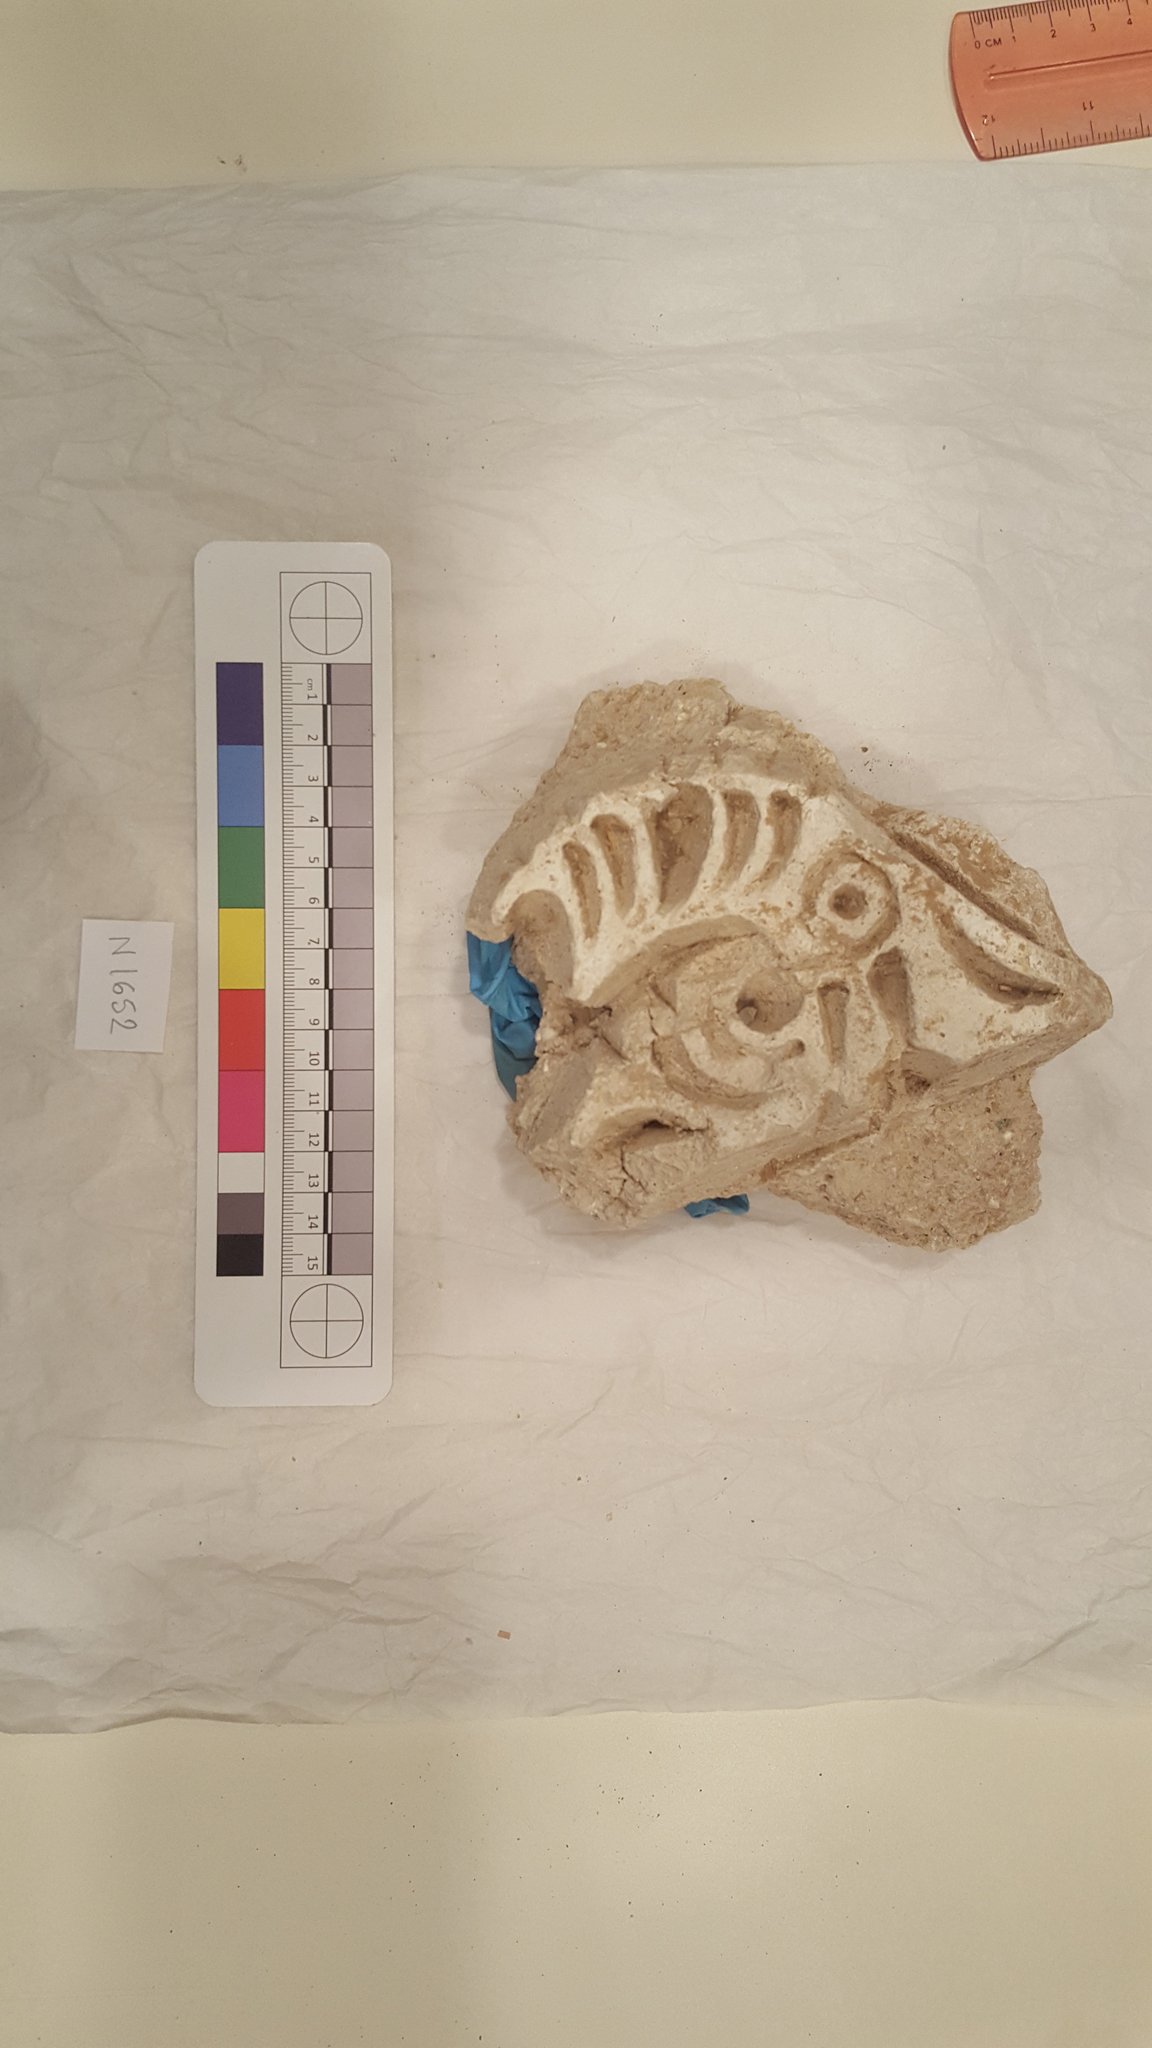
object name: fragment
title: Stucco Fragment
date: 701-1200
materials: plaster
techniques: carving, painting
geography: iran